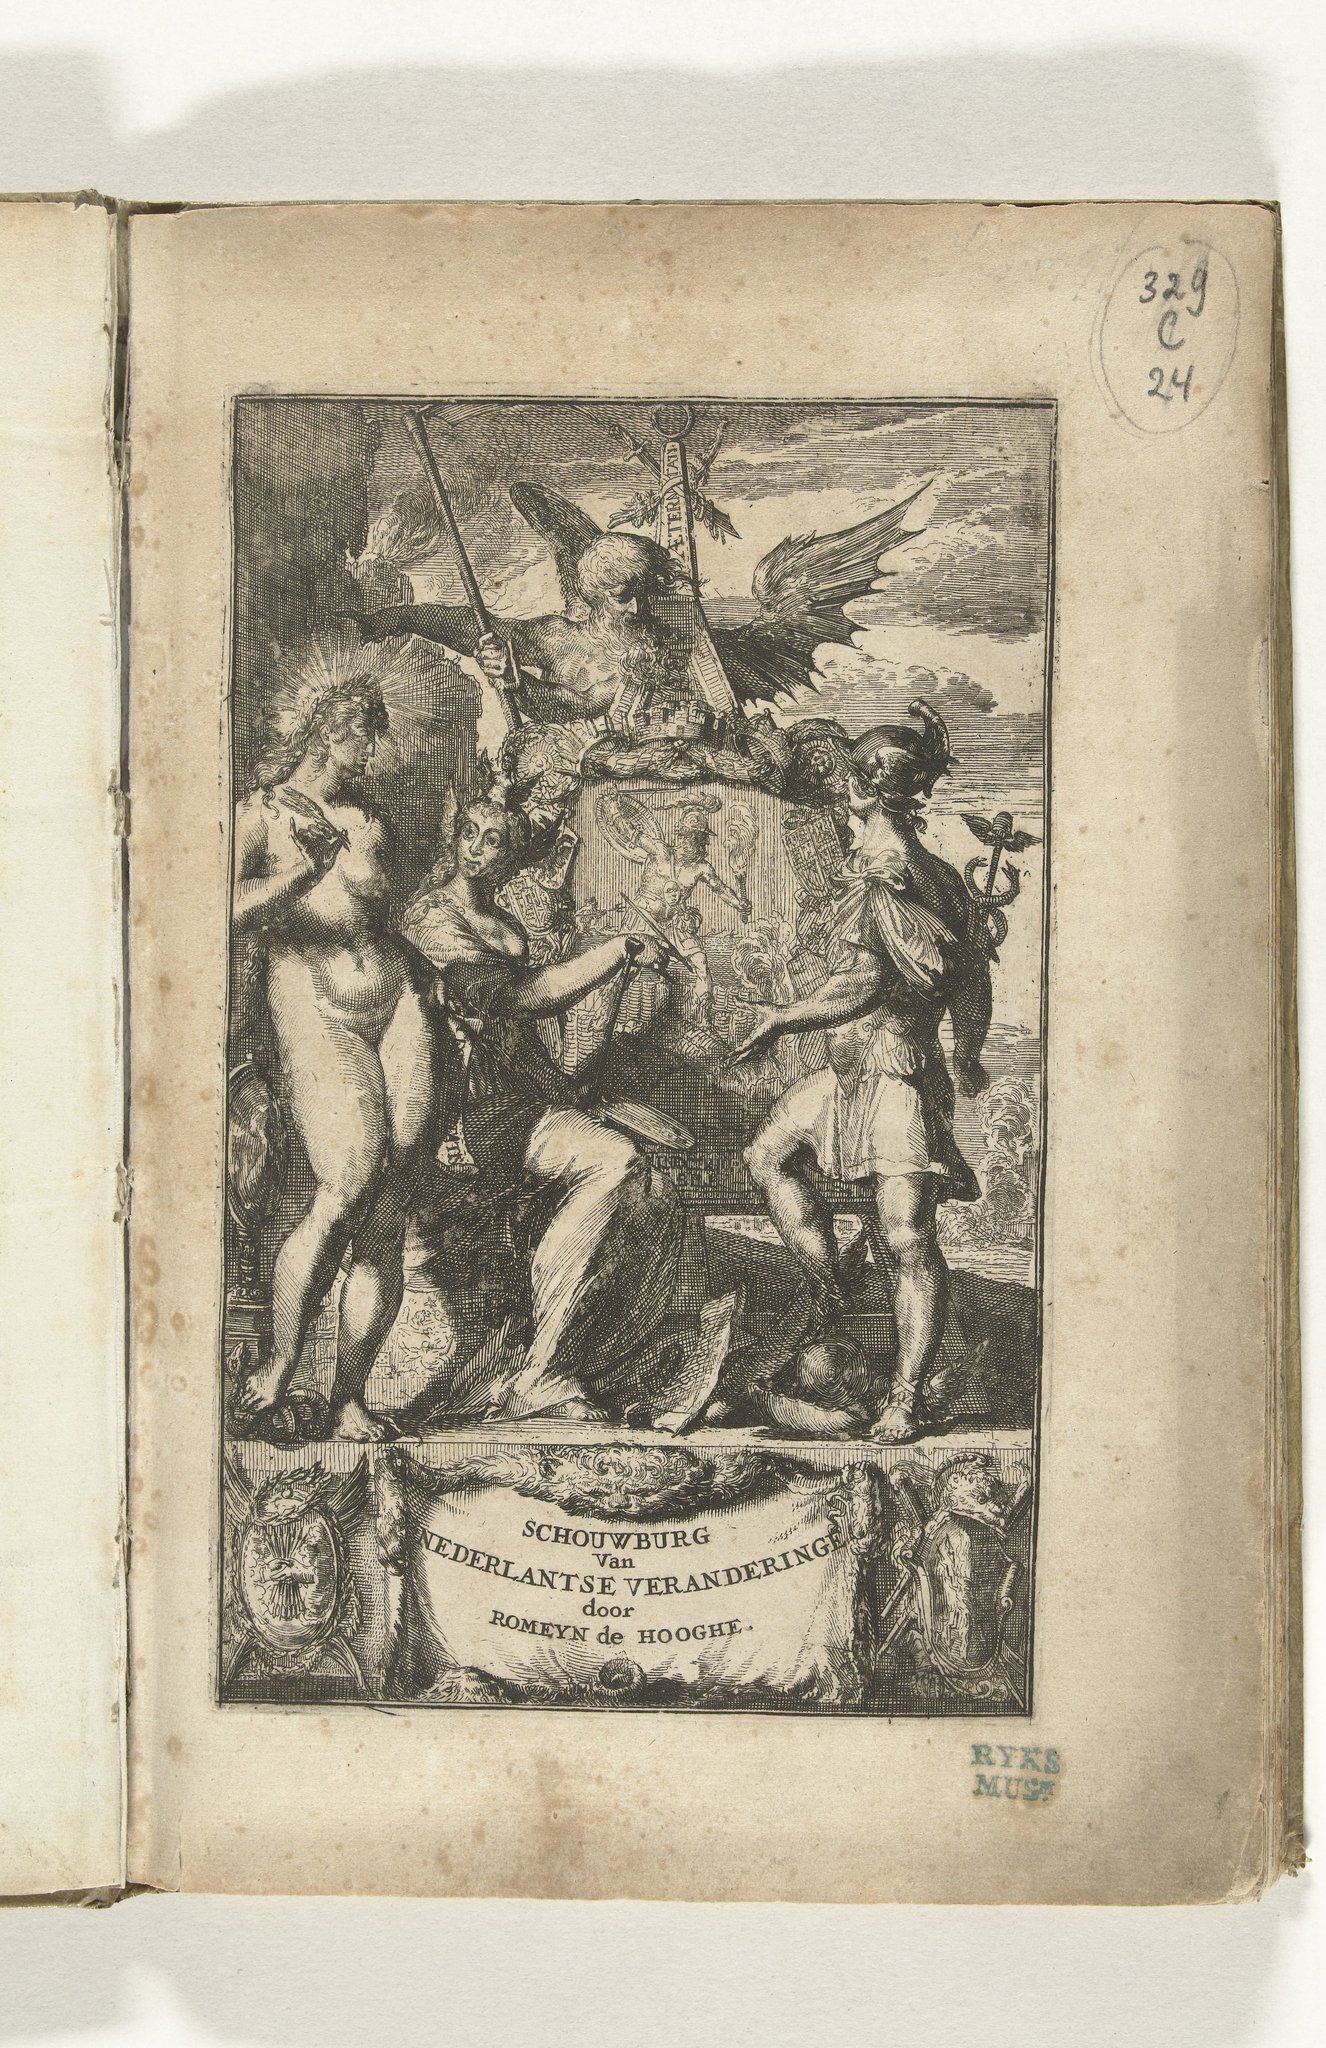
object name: propagandaprent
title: Schouwburg van Nederlantse Veranderinge door Romeyn de Hooghe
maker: romeyn de hooghe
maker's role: draughtsman, goldsmith, painter, print maker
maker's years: 1645-1708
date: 1674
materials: paper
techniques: engraving, etching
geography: amsterdam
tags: truth; 'verità' (ripa), art (+ painting), specific aspects, allegorical aspects of mercury; mercury as patron, father time, man with wings and scythe, netherlands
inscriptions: collector's mark: Lugt 2165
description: Allegorische titelpagina voor: Schouburgh der Nederlandse veranderingen, geopent in ses tooneelen, geschreven en uitgegeven door Romeyn de Hooghe in 1674. De Waarheid, Mercurius en Tijd zien toe hoe een schilderij wordt geschilderd waarin oorlog woedt in de Hollandse Tuin. Hieronder de titel op een opgespannen vel.